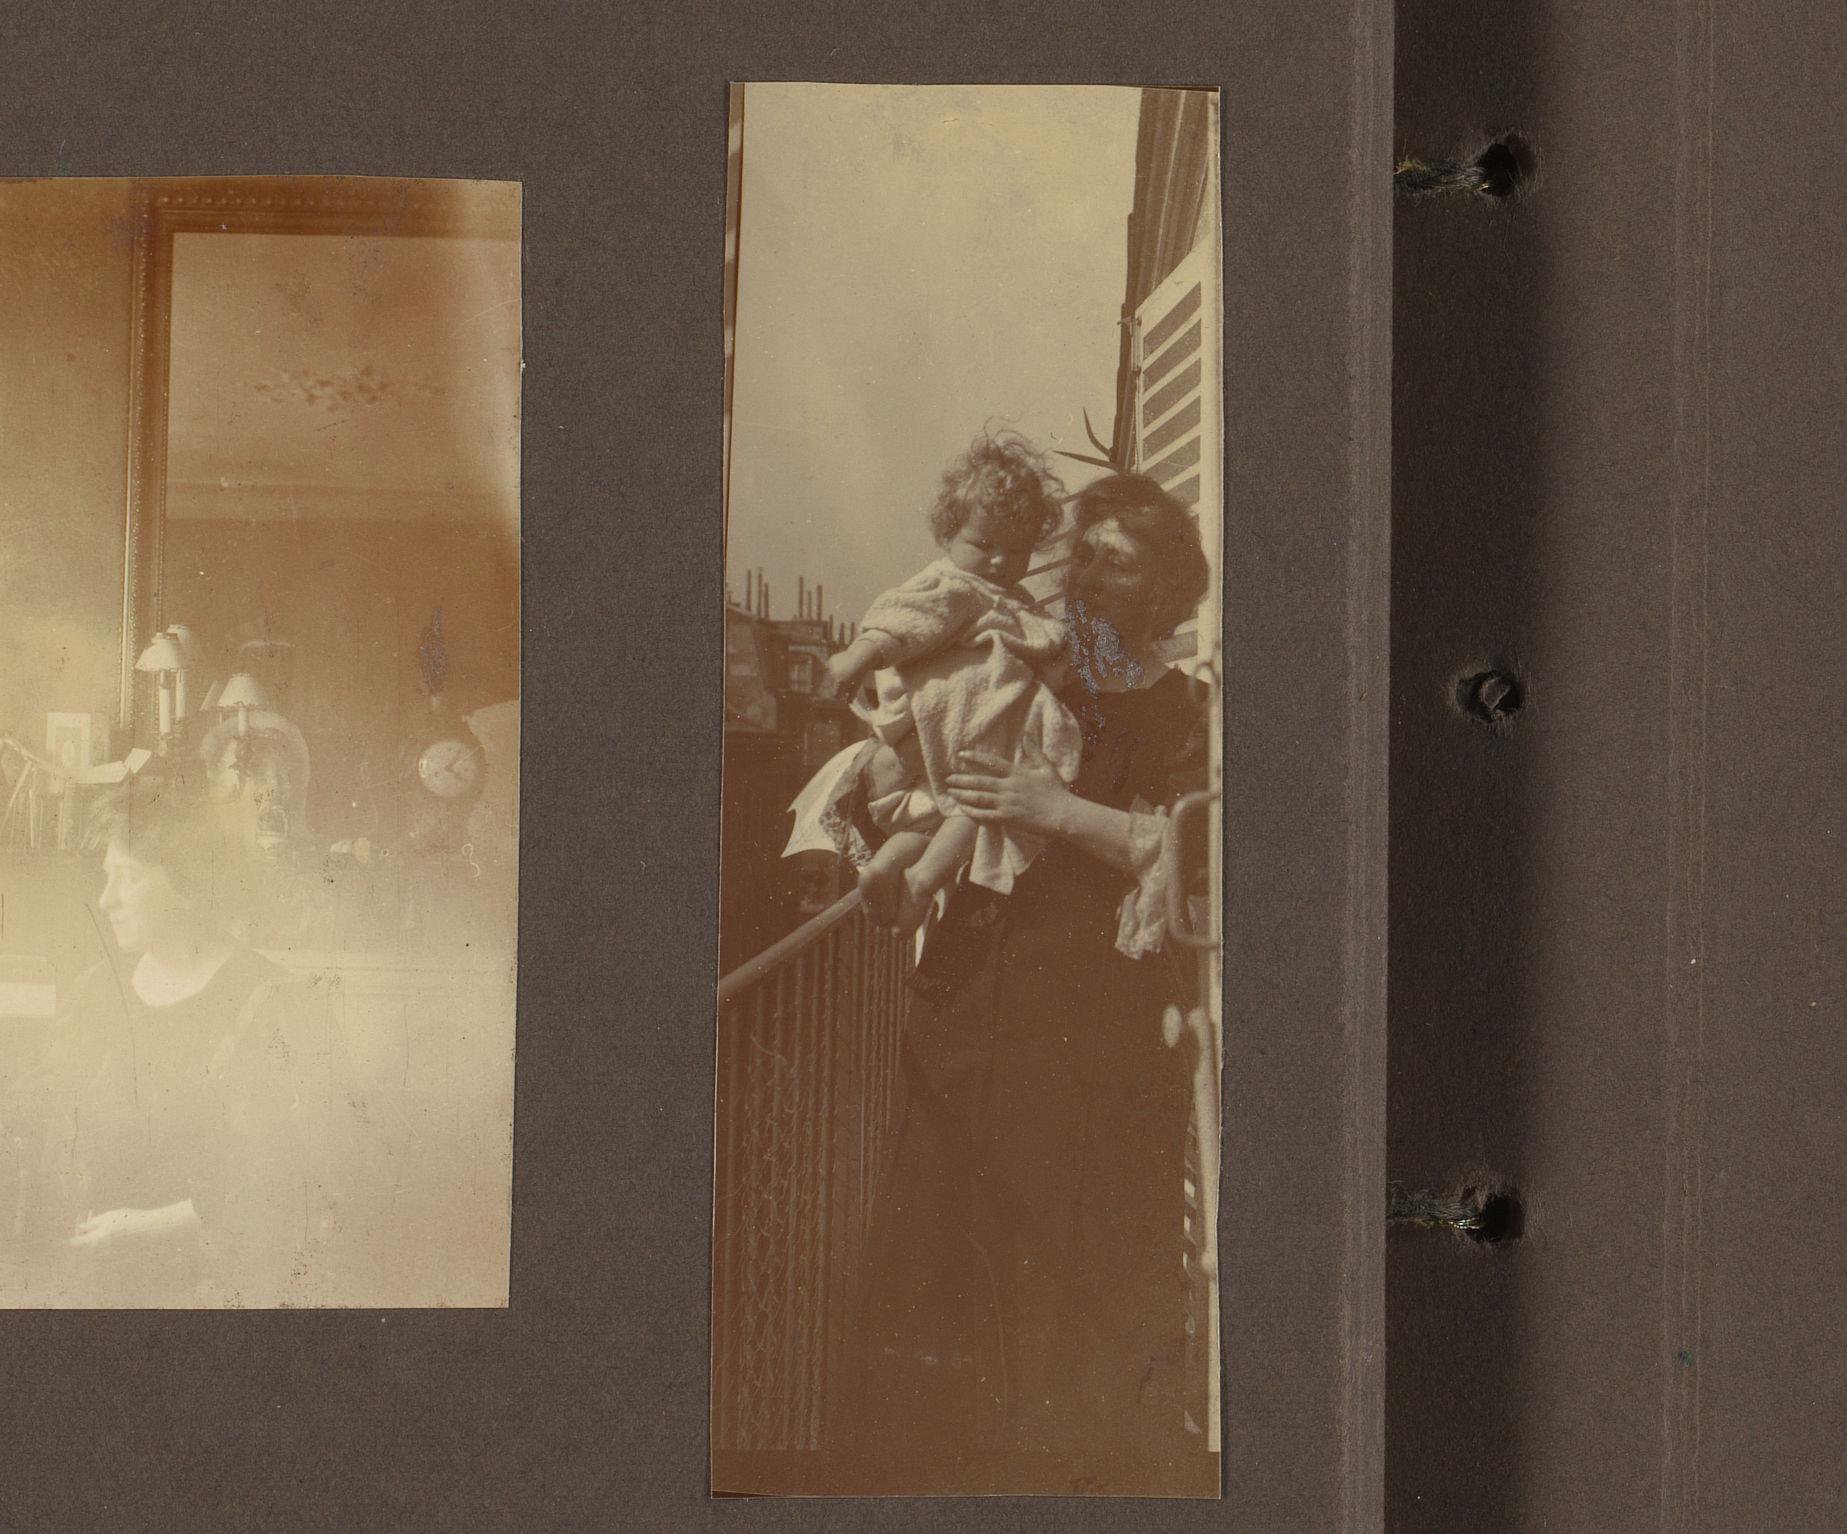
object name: photograph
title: Elsa Diepenbrock op een balkon met een peuter op de arm, vermoedelijk haar dochter Thea of Joanna Diepenbrock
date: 1905-1915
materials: paper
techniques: daylight paper print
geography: paris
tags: amsterdam, jonkvrouw wilhelmina elisabeth petronella cornelia de jong van beek en donk, mother with daughter(s) (mother-love), historical persons - bb - woman, balcony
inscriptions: inscription: ‘Rue de L'Université 12’